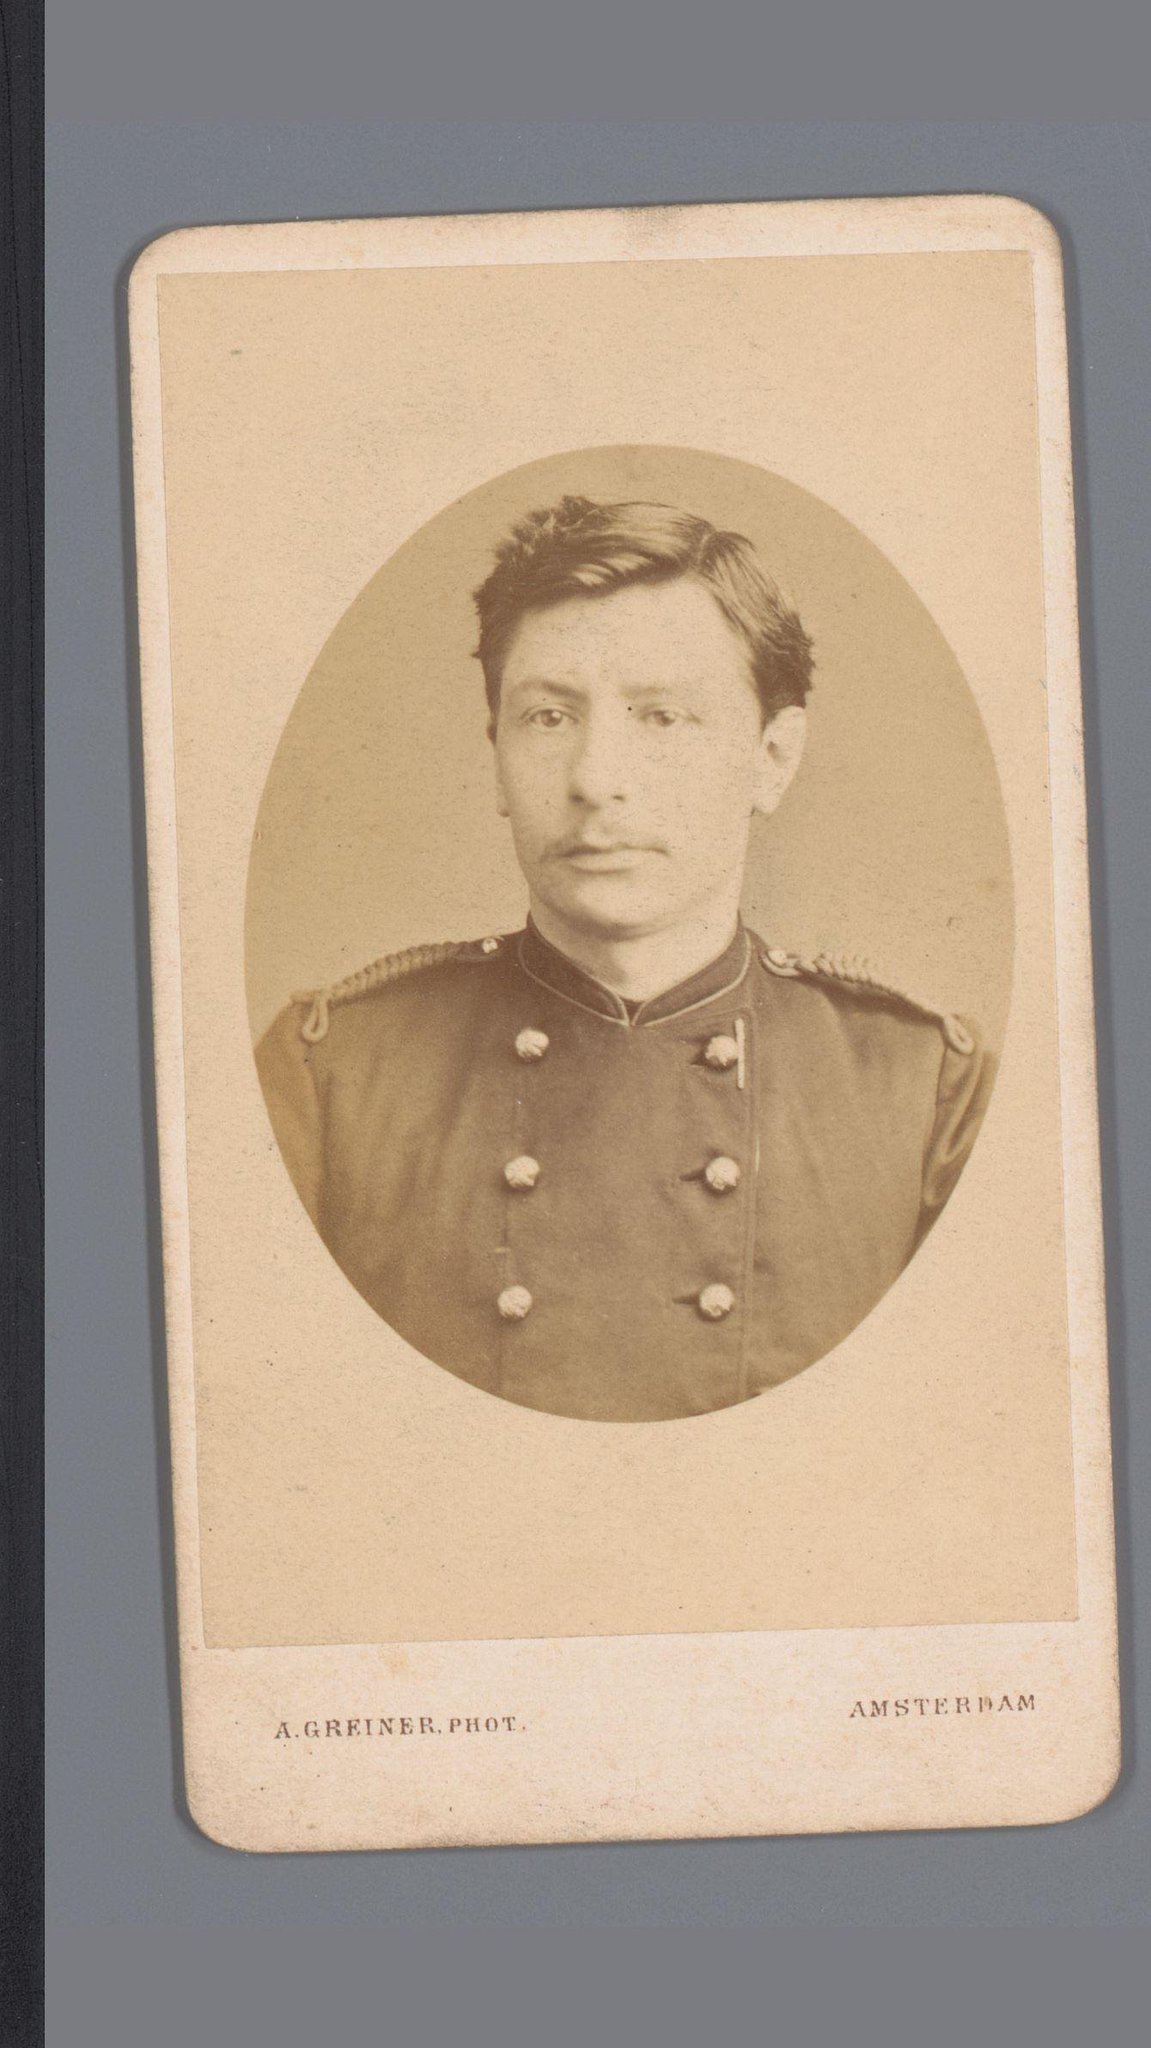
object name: photograph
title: Portret van een onbekende man in uniform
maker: albert greiner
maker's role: fotograaf, fotostudio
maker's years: 1833-1890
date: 1861-1874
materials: cardboard, paper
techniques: albumen print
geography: amsterdam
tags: adult man, historical persons, (military) uniforms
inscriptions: inscription: ‘AG/ A. GREINER/ Photograf/ NIEUWENDIJK L. 87/ AMSTERDAM’